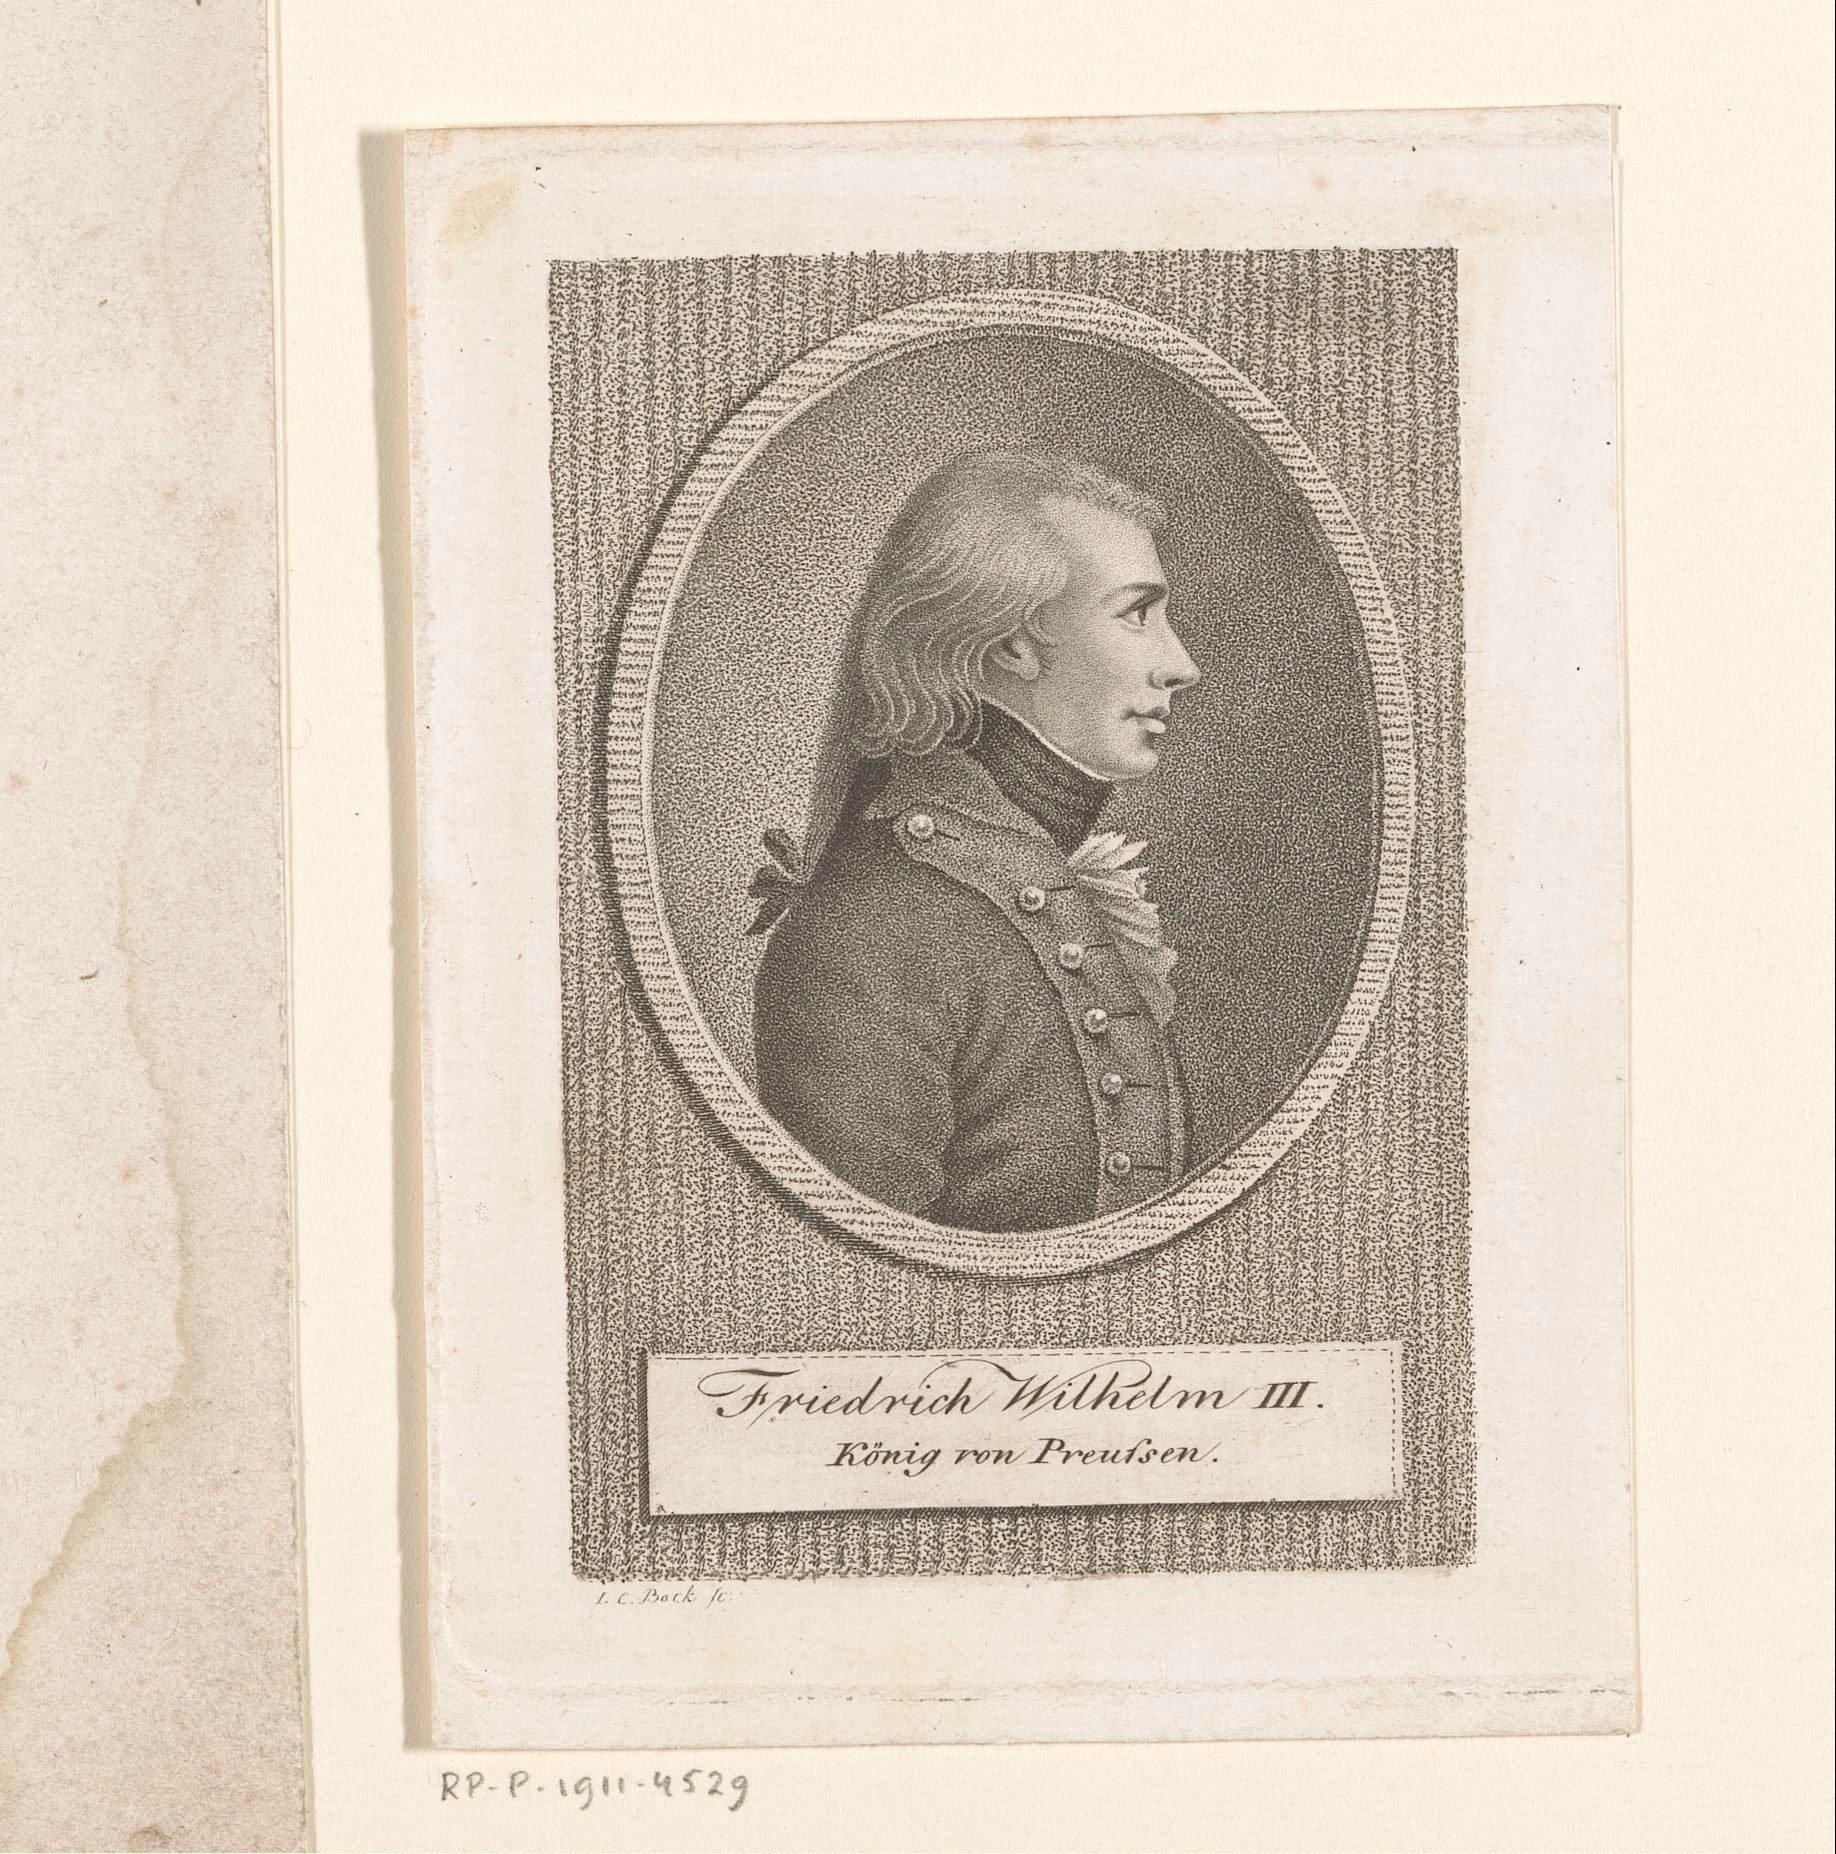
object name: print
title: Portret van Frederik Willem III, koning van Pruisen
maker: johann carl bock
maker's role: print maker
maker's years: 1757-1843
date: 1797-1843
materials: paper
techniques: etching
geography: nuremberg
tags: frederik willem iii koning van pruisen, historical persons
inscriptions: collector's mark: Lugt 2228